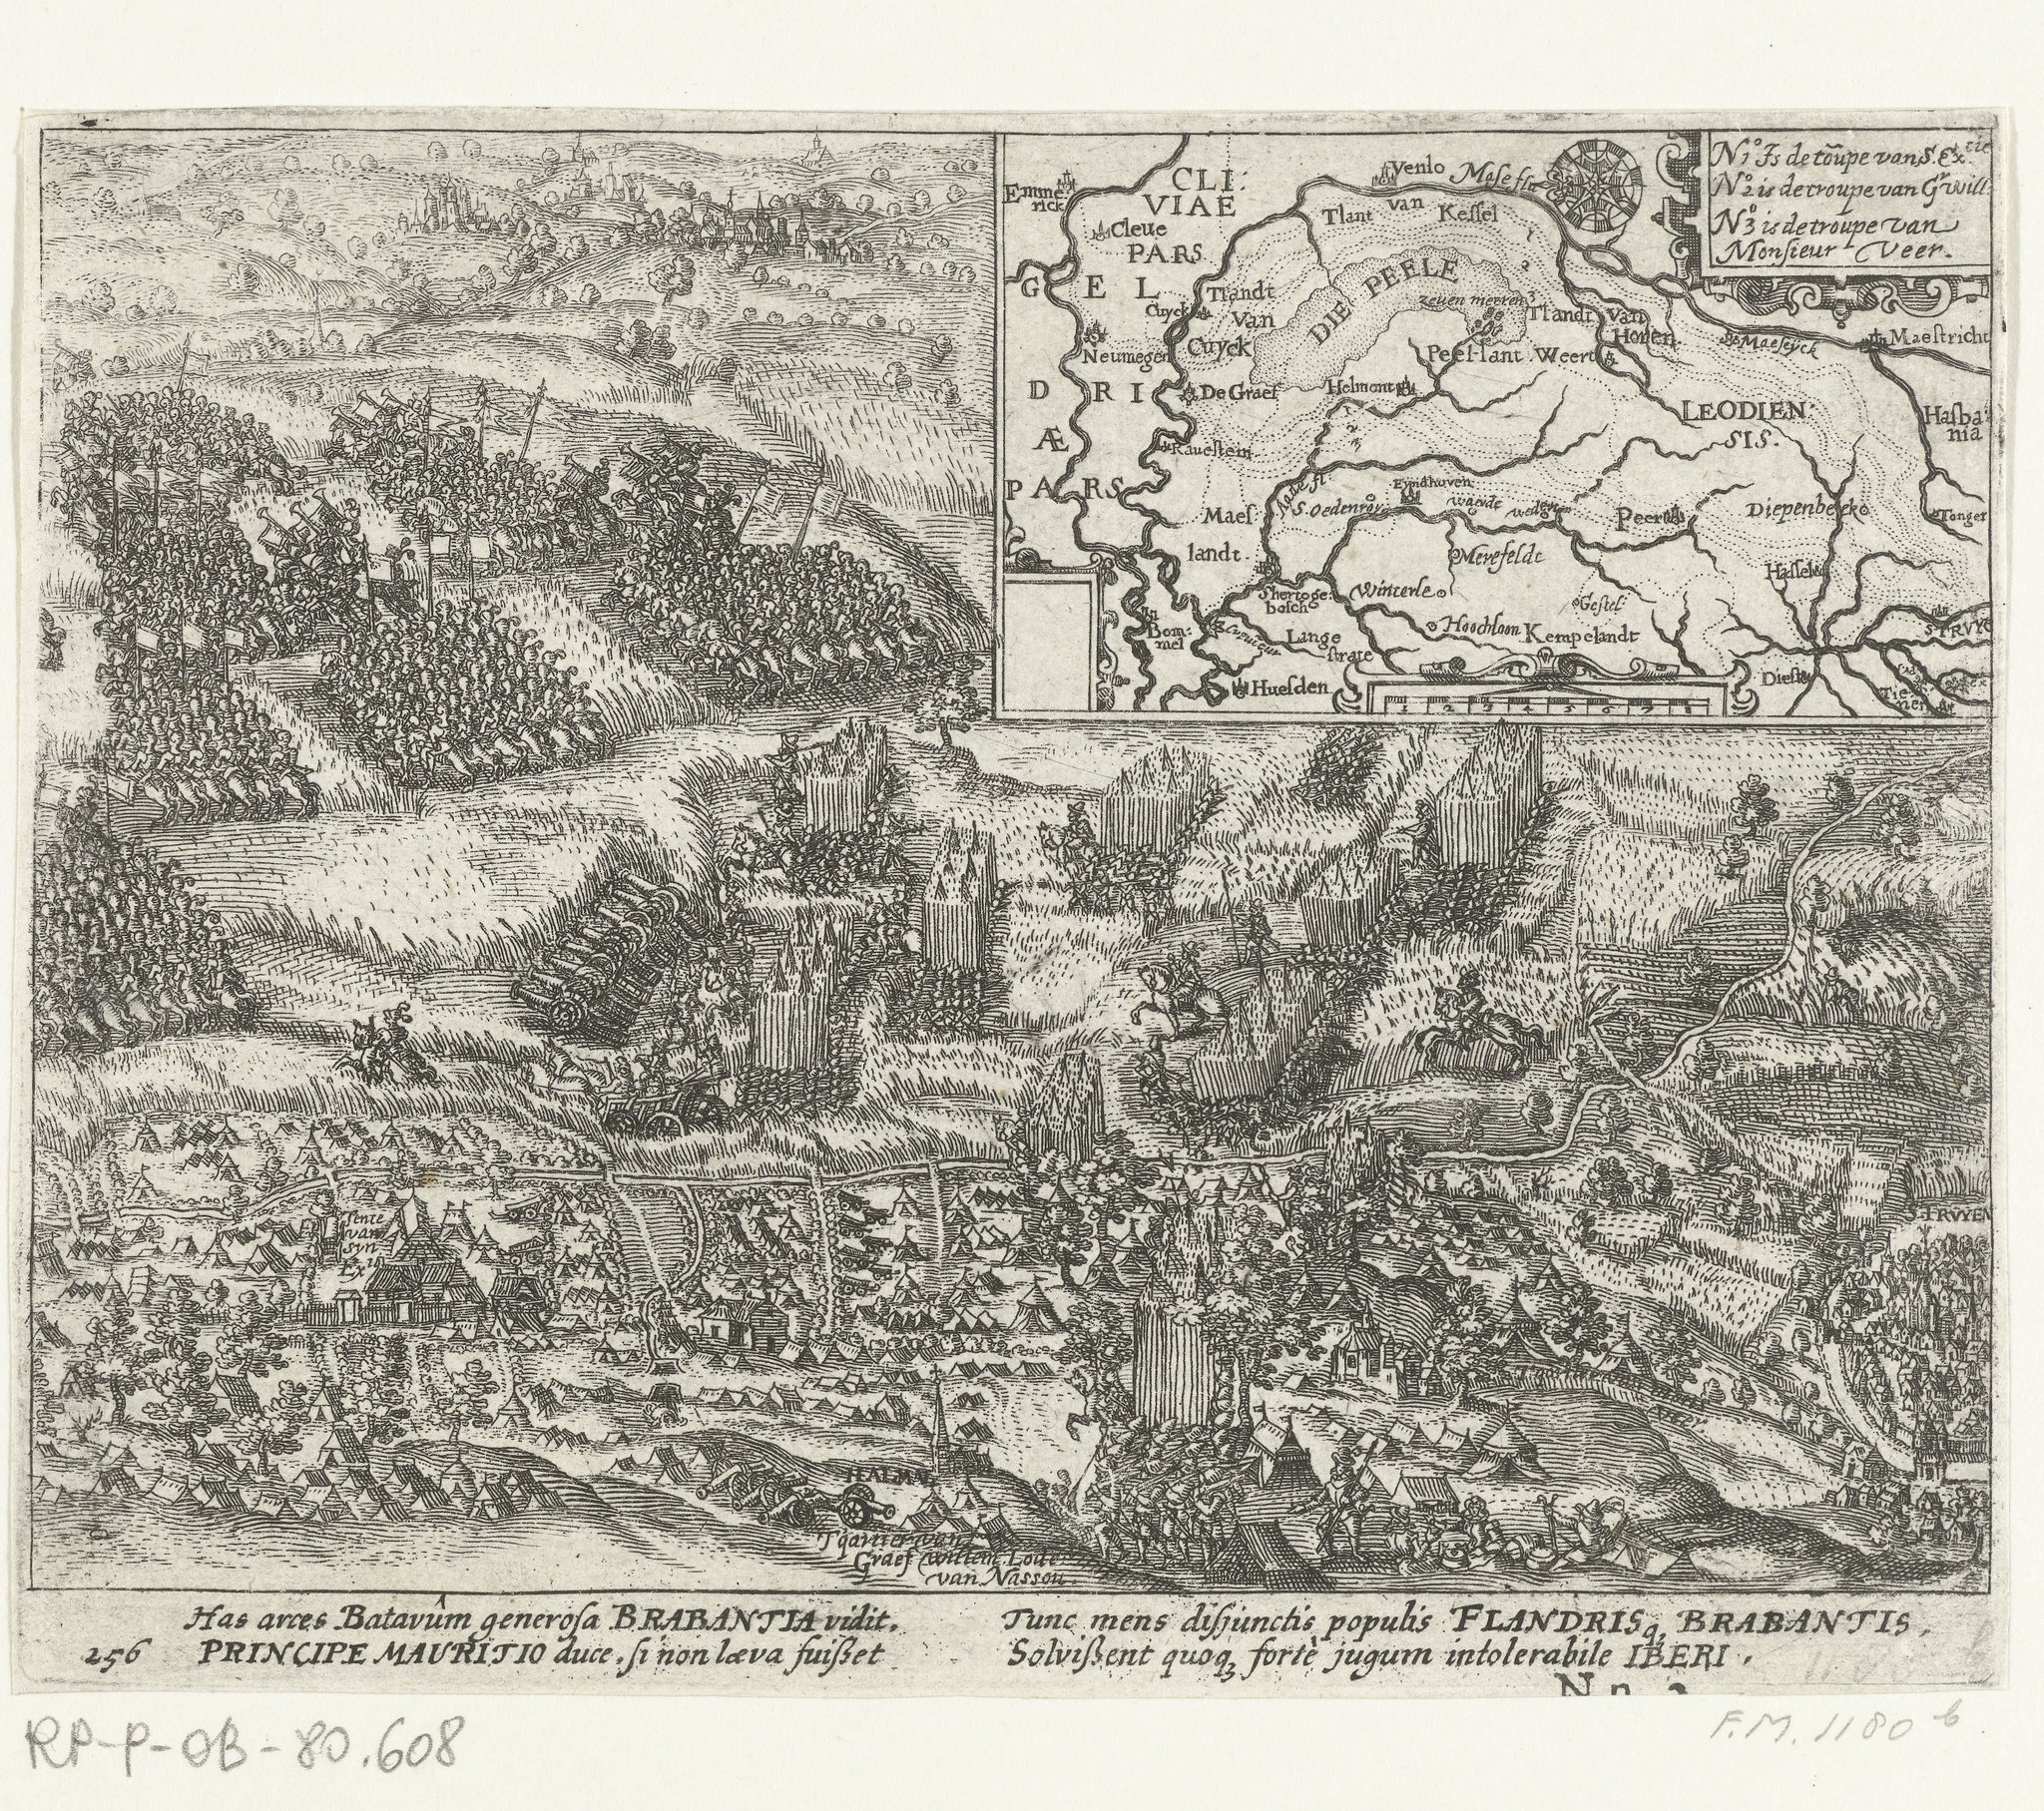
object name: print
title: De tocht door Brabant: het Staatse leger voor Tienen (rechterhelft), 1602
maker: Anonymous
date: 1613-1615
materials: paper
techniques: etching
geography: northern netherlands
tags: maurice (prince of orange), willem lodewijk graaf van nassau-dillenburg, transport, train (military)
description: De tocht door Brabant: het Staatse Leger onder prins Maurits voor Tienen, 7 juli 1602. Rechterhelft van geheel van twee bladen. Op de voorgrond het kwartier van graaf Willem Lodewijk van Nassau, rechtsboven een inzet met een kaartje van het groter gebied. Met onderschrift van twee regels in het Latijn, genummerd: 256. Bedrukt op achterzijde met tekst in het Latijn.